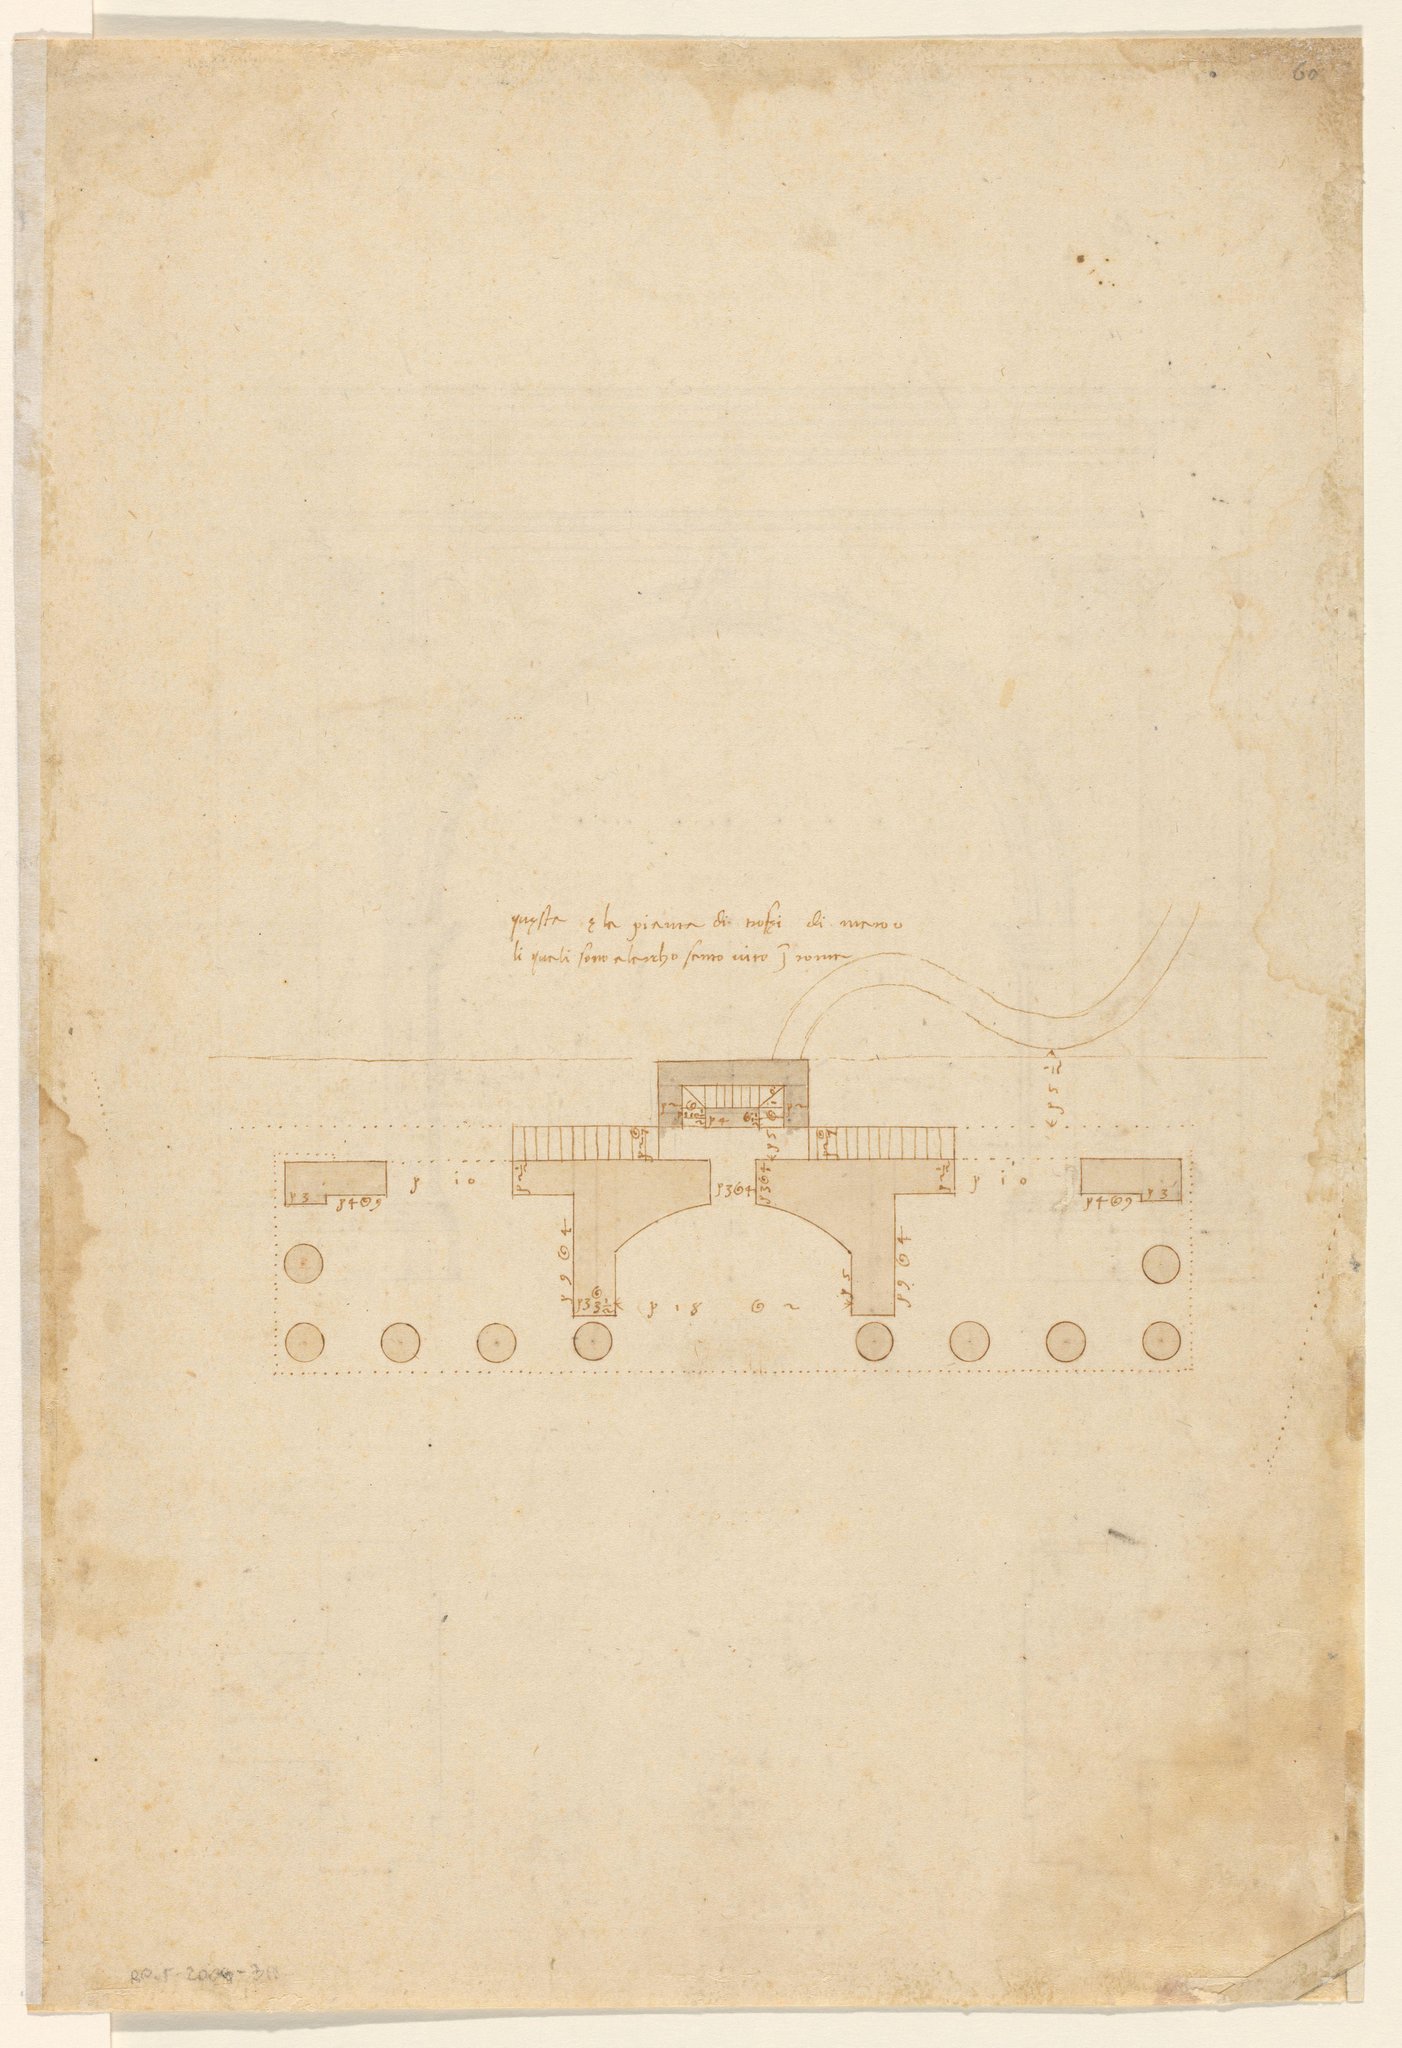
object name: drawing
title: Plattegrond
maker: andrea palladio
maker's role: architect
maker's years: 1508-1580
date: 1518-1580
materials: ink, paper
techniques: brush, pen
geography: italy